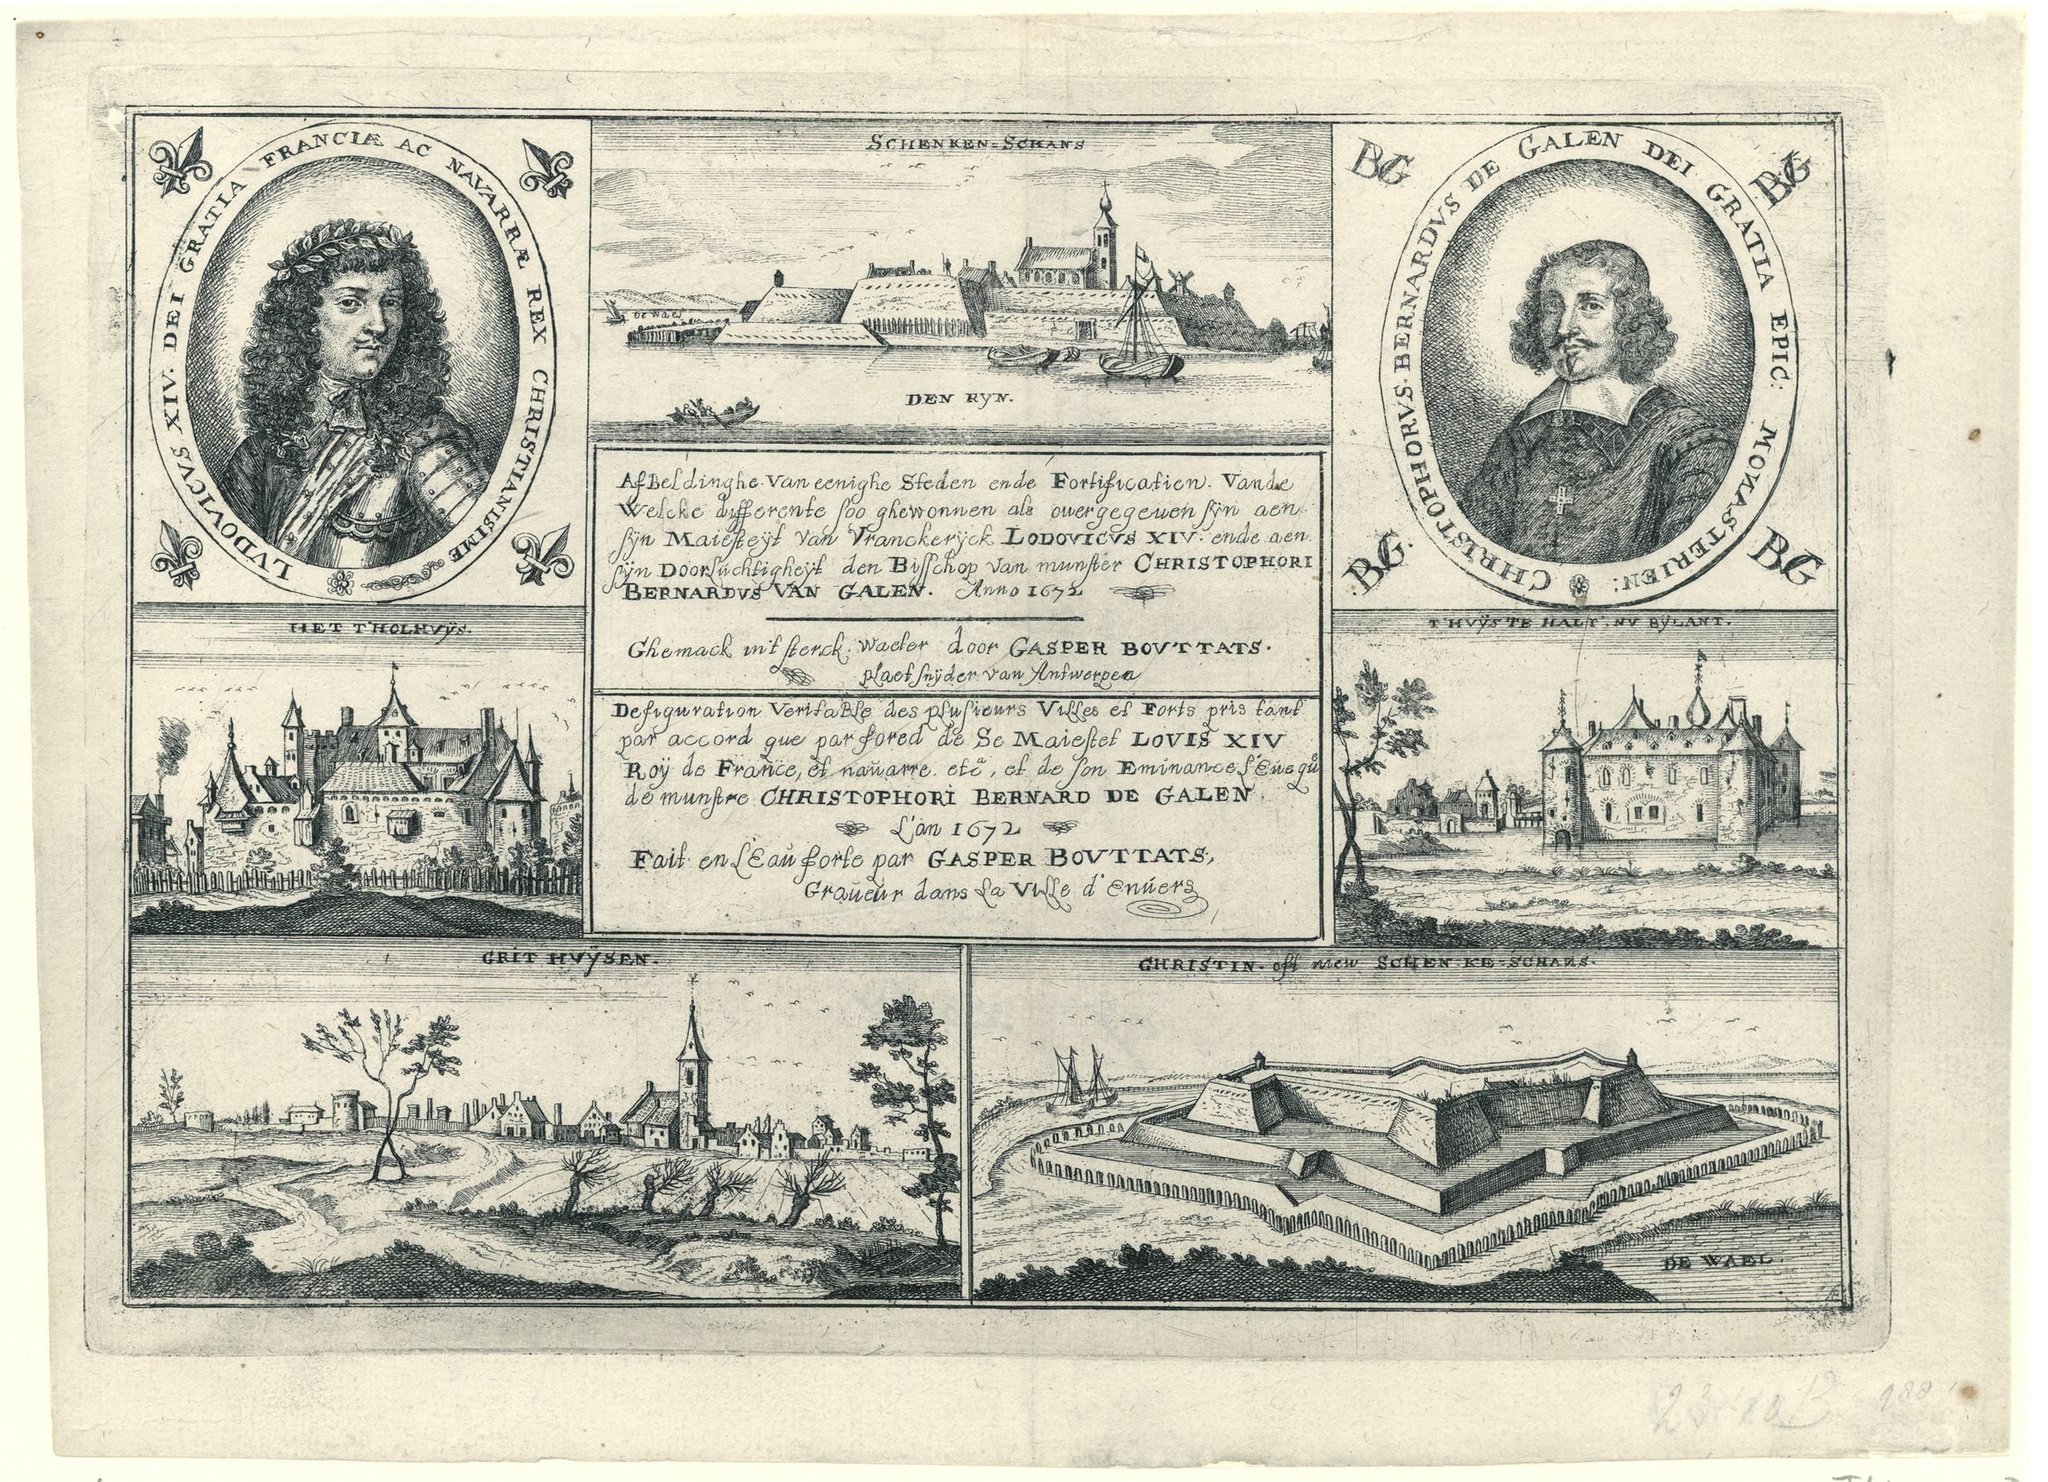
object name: titelprent, frontispice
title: Afbeeldinghe van eenighe Steden ende Fortificatien Van de welcke differente soo ghewonnen als overgegeven zijn aen sijn Majesteyt van Vranckerijk Lodovicus XIV ende aen sijn Doorluchtighijt den Bisschop van Munster Christophori Bernardus van Galen. Anno 1672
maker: gaspar bouttats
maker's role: print maker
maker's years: 1640-1695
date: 1672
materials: paper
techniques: etching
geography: antwerp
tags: lodewijk xiv (koning van frankrijk), rampjaar (disaster year)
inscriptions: date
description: Blad met portretten van de koning van Frankrijk en de bisschop van Munster en vijf steden of vestingen waarover gevochten is. Deze worden in de prent genoemd: Schenken-Schans (Schenkenschans), Het T'Holhuys (Tolhuis), Grit Huysen (Griethuizen), Christin off Niew Schenkeschans (Nieuw Schenkenschans) en T'Huys te Halt nu Bylant (kasteel Byland). Titelprent voor een serie van 12 prenten van vestingen veroverd door de Franse en Munsterse troepen in 1672.